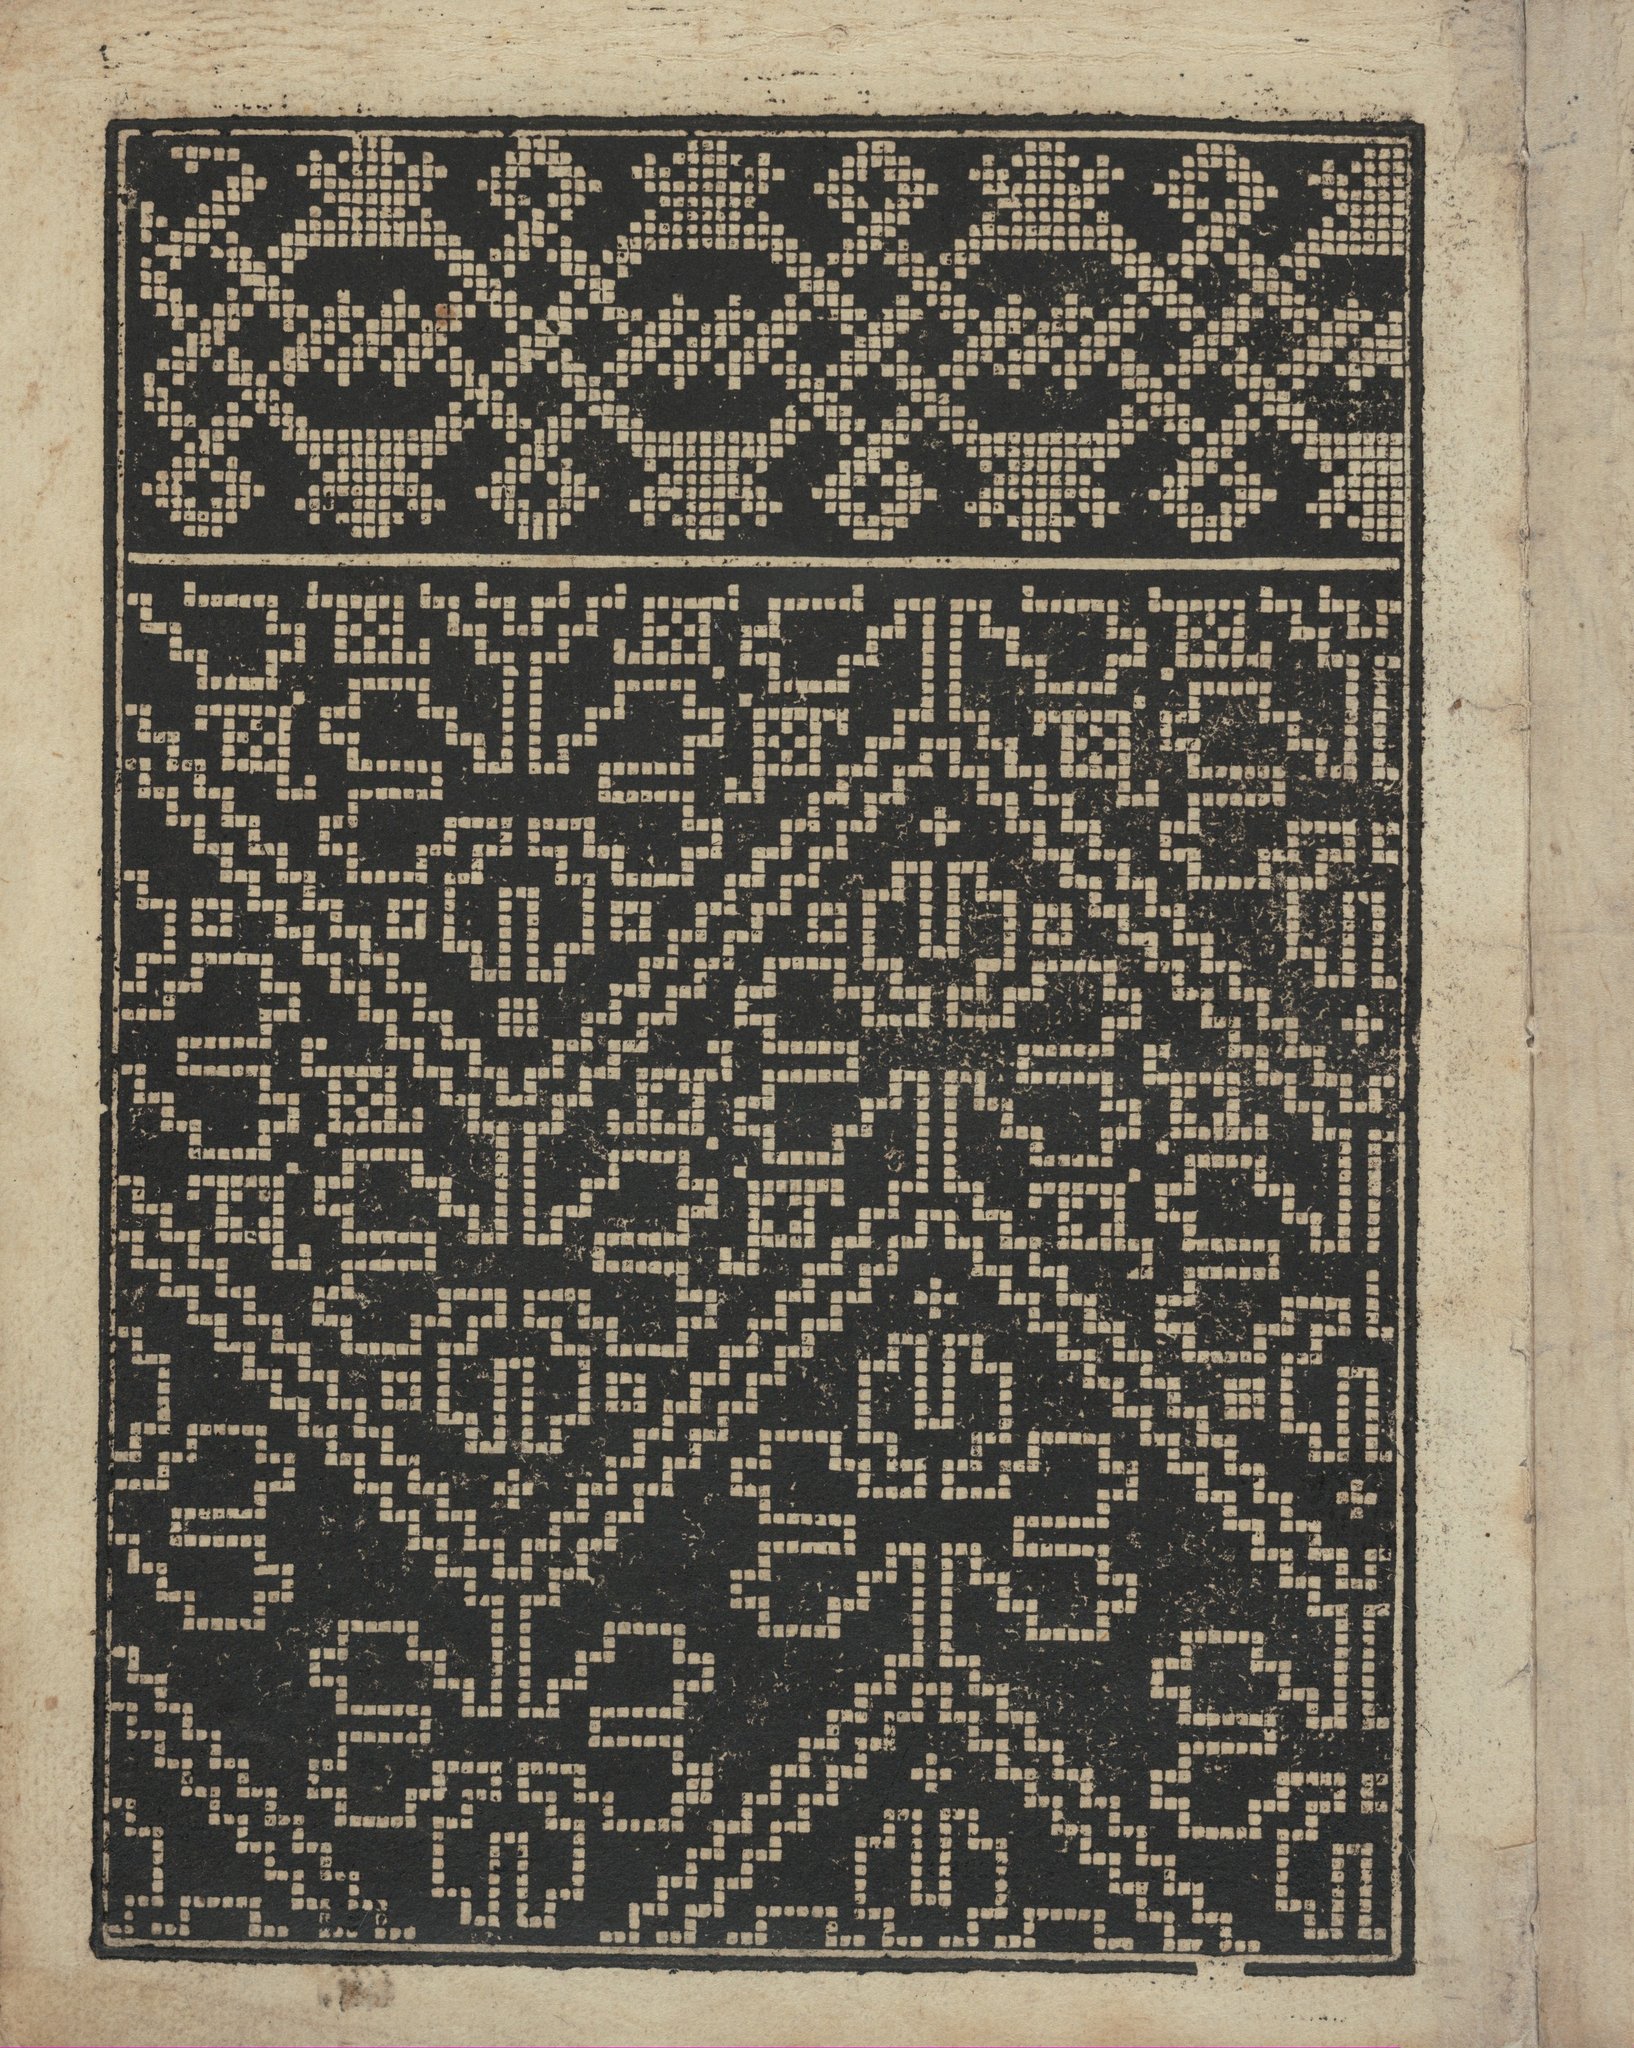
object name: book print ornament architecture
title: Libbretto nouellamete composto per maestro Domenico da Sera...lauorare di ogni sorte di punti, page 5 (verso)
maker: domenico da sera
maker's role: publisher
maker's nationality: french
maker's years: 1500-1599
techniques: woodcut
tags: ornament